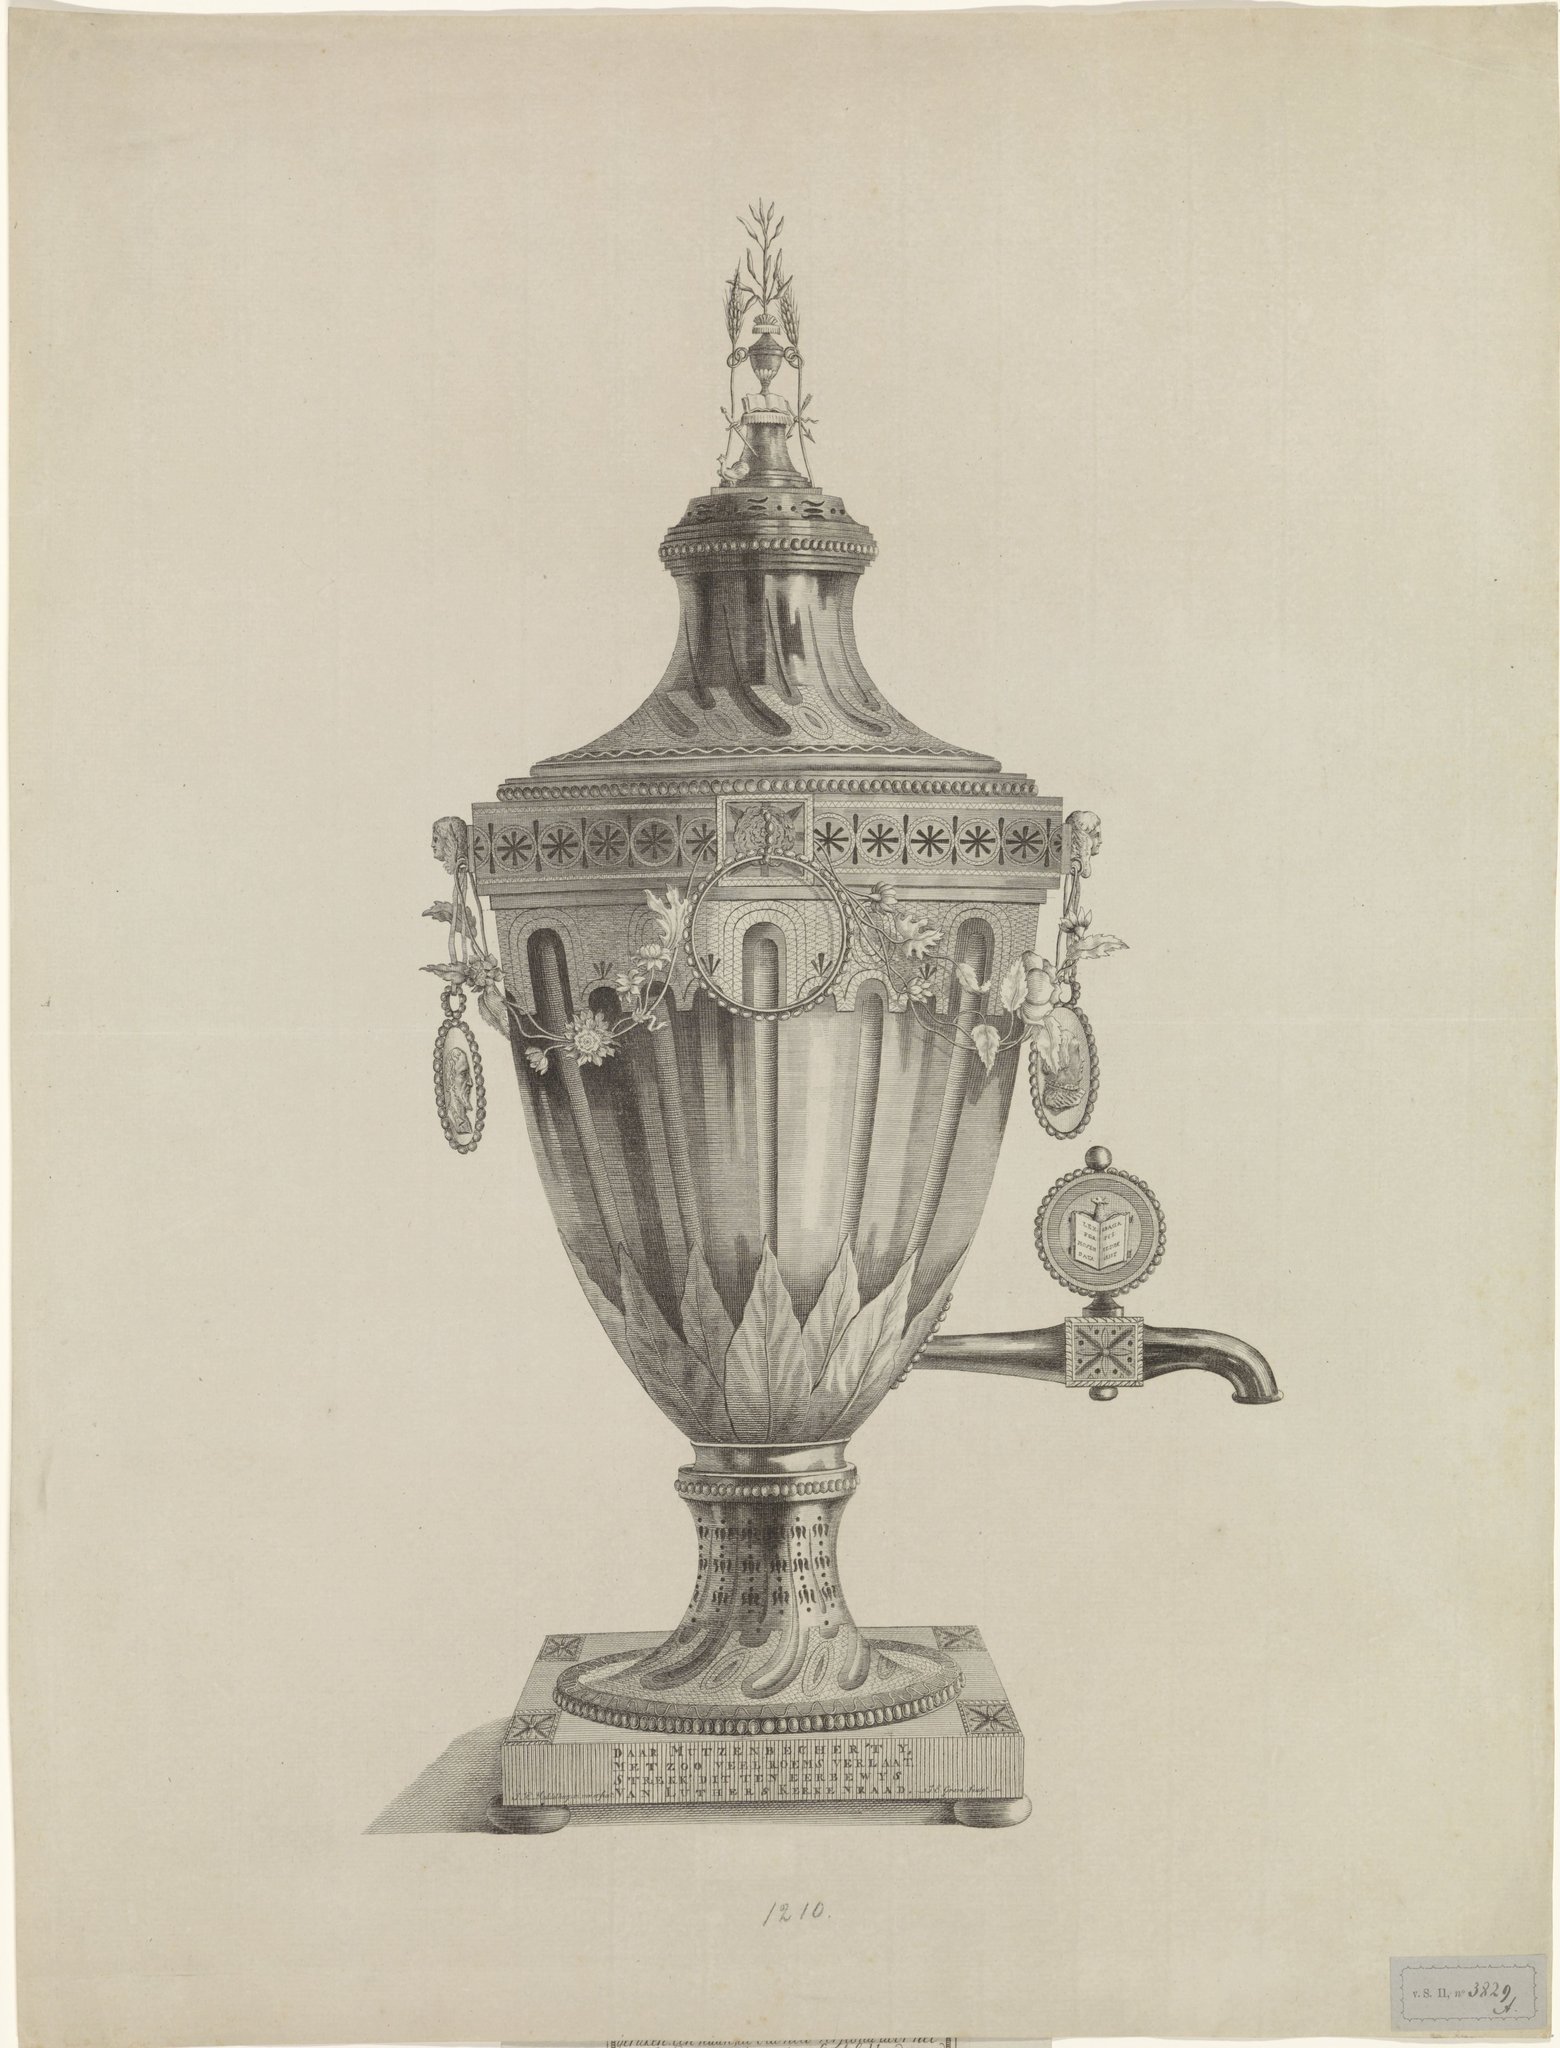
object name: print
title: Ornamentele theepot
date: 1780-1789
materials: paper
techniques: engraving, etching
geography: amsterdam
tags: esdras heinrich mützenbecher, priest, martin luther, tea-pot; samovar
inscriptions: collector's mark: Lugt 2228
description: Een ornamentele theepot met kraan, geschonken aan de heer Esdras Heinrich Mützenbecher door de Lutherse Kerk van Amsterdam. De theepot heeft twee medaillons met respectievelijk de portretten van Luther en Melanchthon. Op het kraantje het Lam Gods met een bijbel. Op het voetstuk een Nederlandse inscriptie.